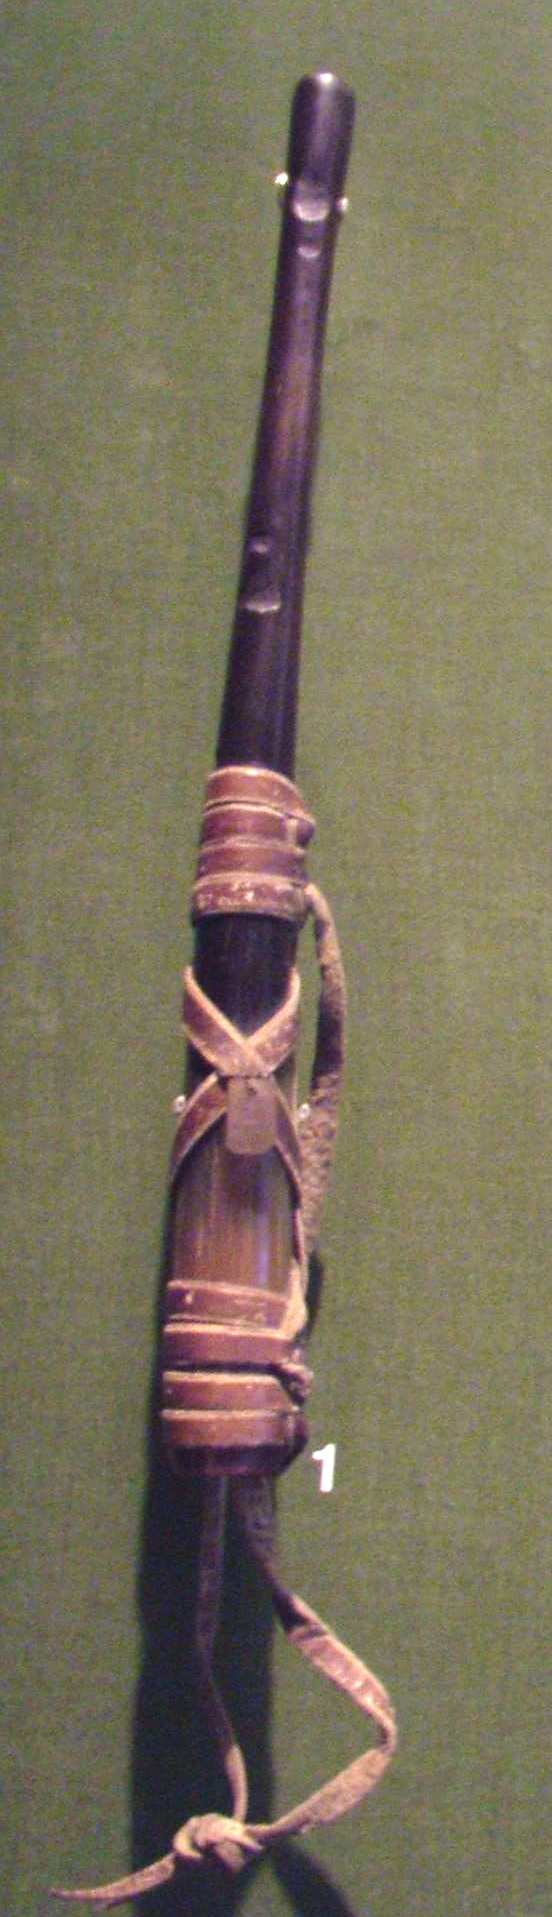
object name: falconer's horn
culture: german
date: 1501-1800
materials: horn, leather, pigment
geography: germany